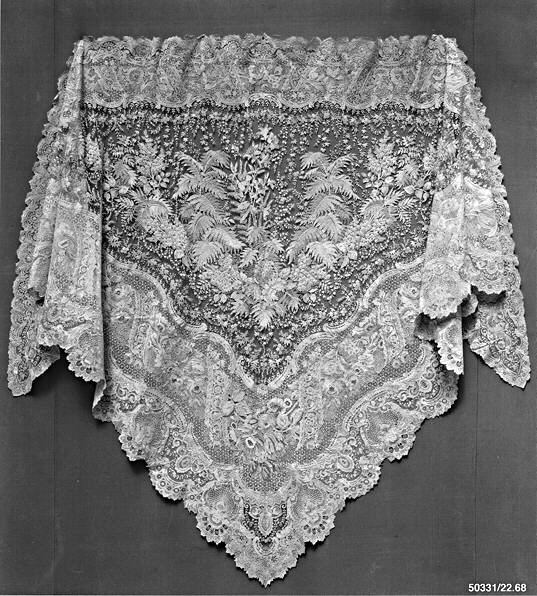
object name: shawl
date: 1801-1900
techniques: lace